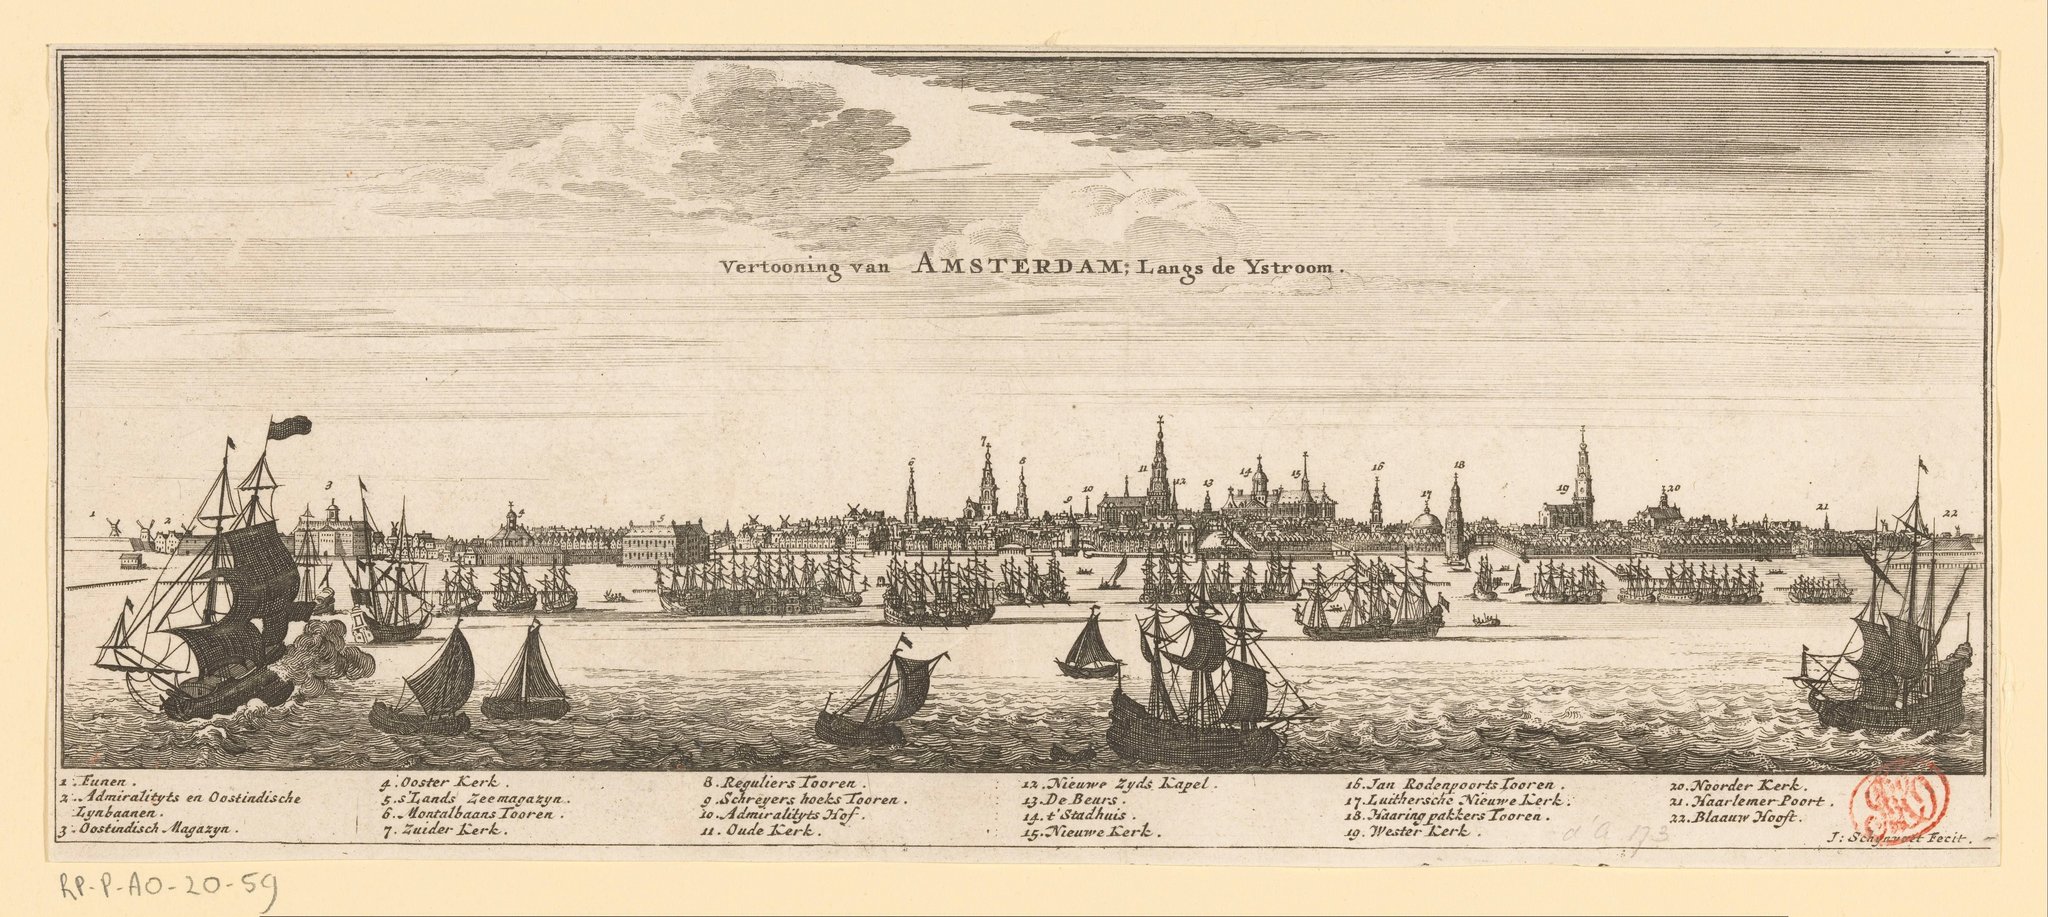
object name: print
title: Gezicht op Amsterdam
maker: jacobus schijnvoet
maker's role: draughtsman, print maker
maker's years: 1685-1743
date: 1713-1751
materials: paper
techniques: engraving, etching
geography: amsterdam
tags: prospect of city, town panorama, silhouette of city, amsterdam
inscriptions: collector's mark: Lugt 195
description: Prent ook gebruikt in: Hoorn, Nicolaas ten. Wegwyzer door Amsterdam, Zynde eene beknopte verhandeling van desselfs eerste opkomst, vergrootingen, en teegenwoordigen staat (…). Amsterdam: Nicolaas ten Hoorn, 1713. En in: Hoorn, Nicolaas ten. Wegwyzer door Amsterdam, Zynde eene beknopte verhandeling van desselfs eerste opkomst, vergrootingen, en teegenwoordigen staat (…). Amsterdam: Nicolaas ten Hoorn, 1726. En in: Hoorn, Nicolaas ten. Wegwyzer, of korte beschryvinge Van de Stadt Amsterdam, Zynde eene beknopte Verhandeling van desselfs eerste opkomst, vergrootingen, en tegenwoordigen staat (…). Amsterdam: erven J. Ratelband & Co, 1737. En in: Hoorn, Nicolaas ten. Wegwyzer of korte beschryvinge der stad Amsterdam. Zynde eene Beknopte Verhandeling van derzelver eerste Opkomst, Vergrootingen en Tegenwoordigen Staat (…). Amsterdam: Pieter Meyer, 1751.